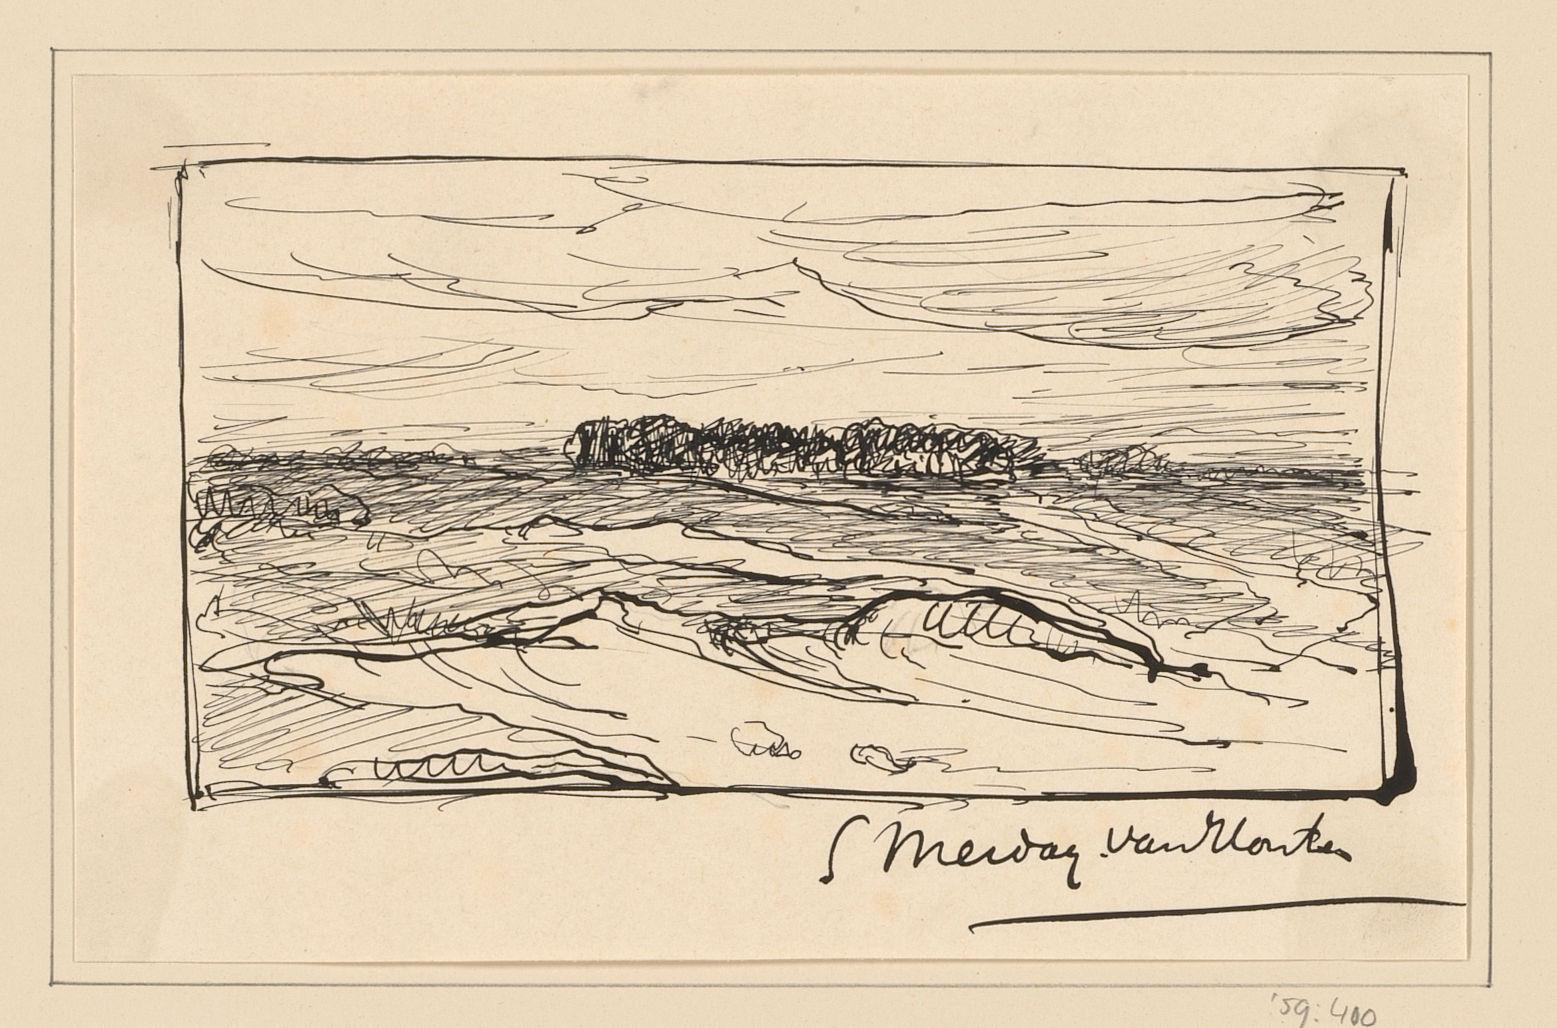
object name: drawing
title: Landschap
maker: sientje mesdag-van houten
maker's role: draughtsman, painter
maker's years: 1834-1909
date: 1856-1909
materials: ink, paper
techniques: pen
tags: landscapes in the temperate zone